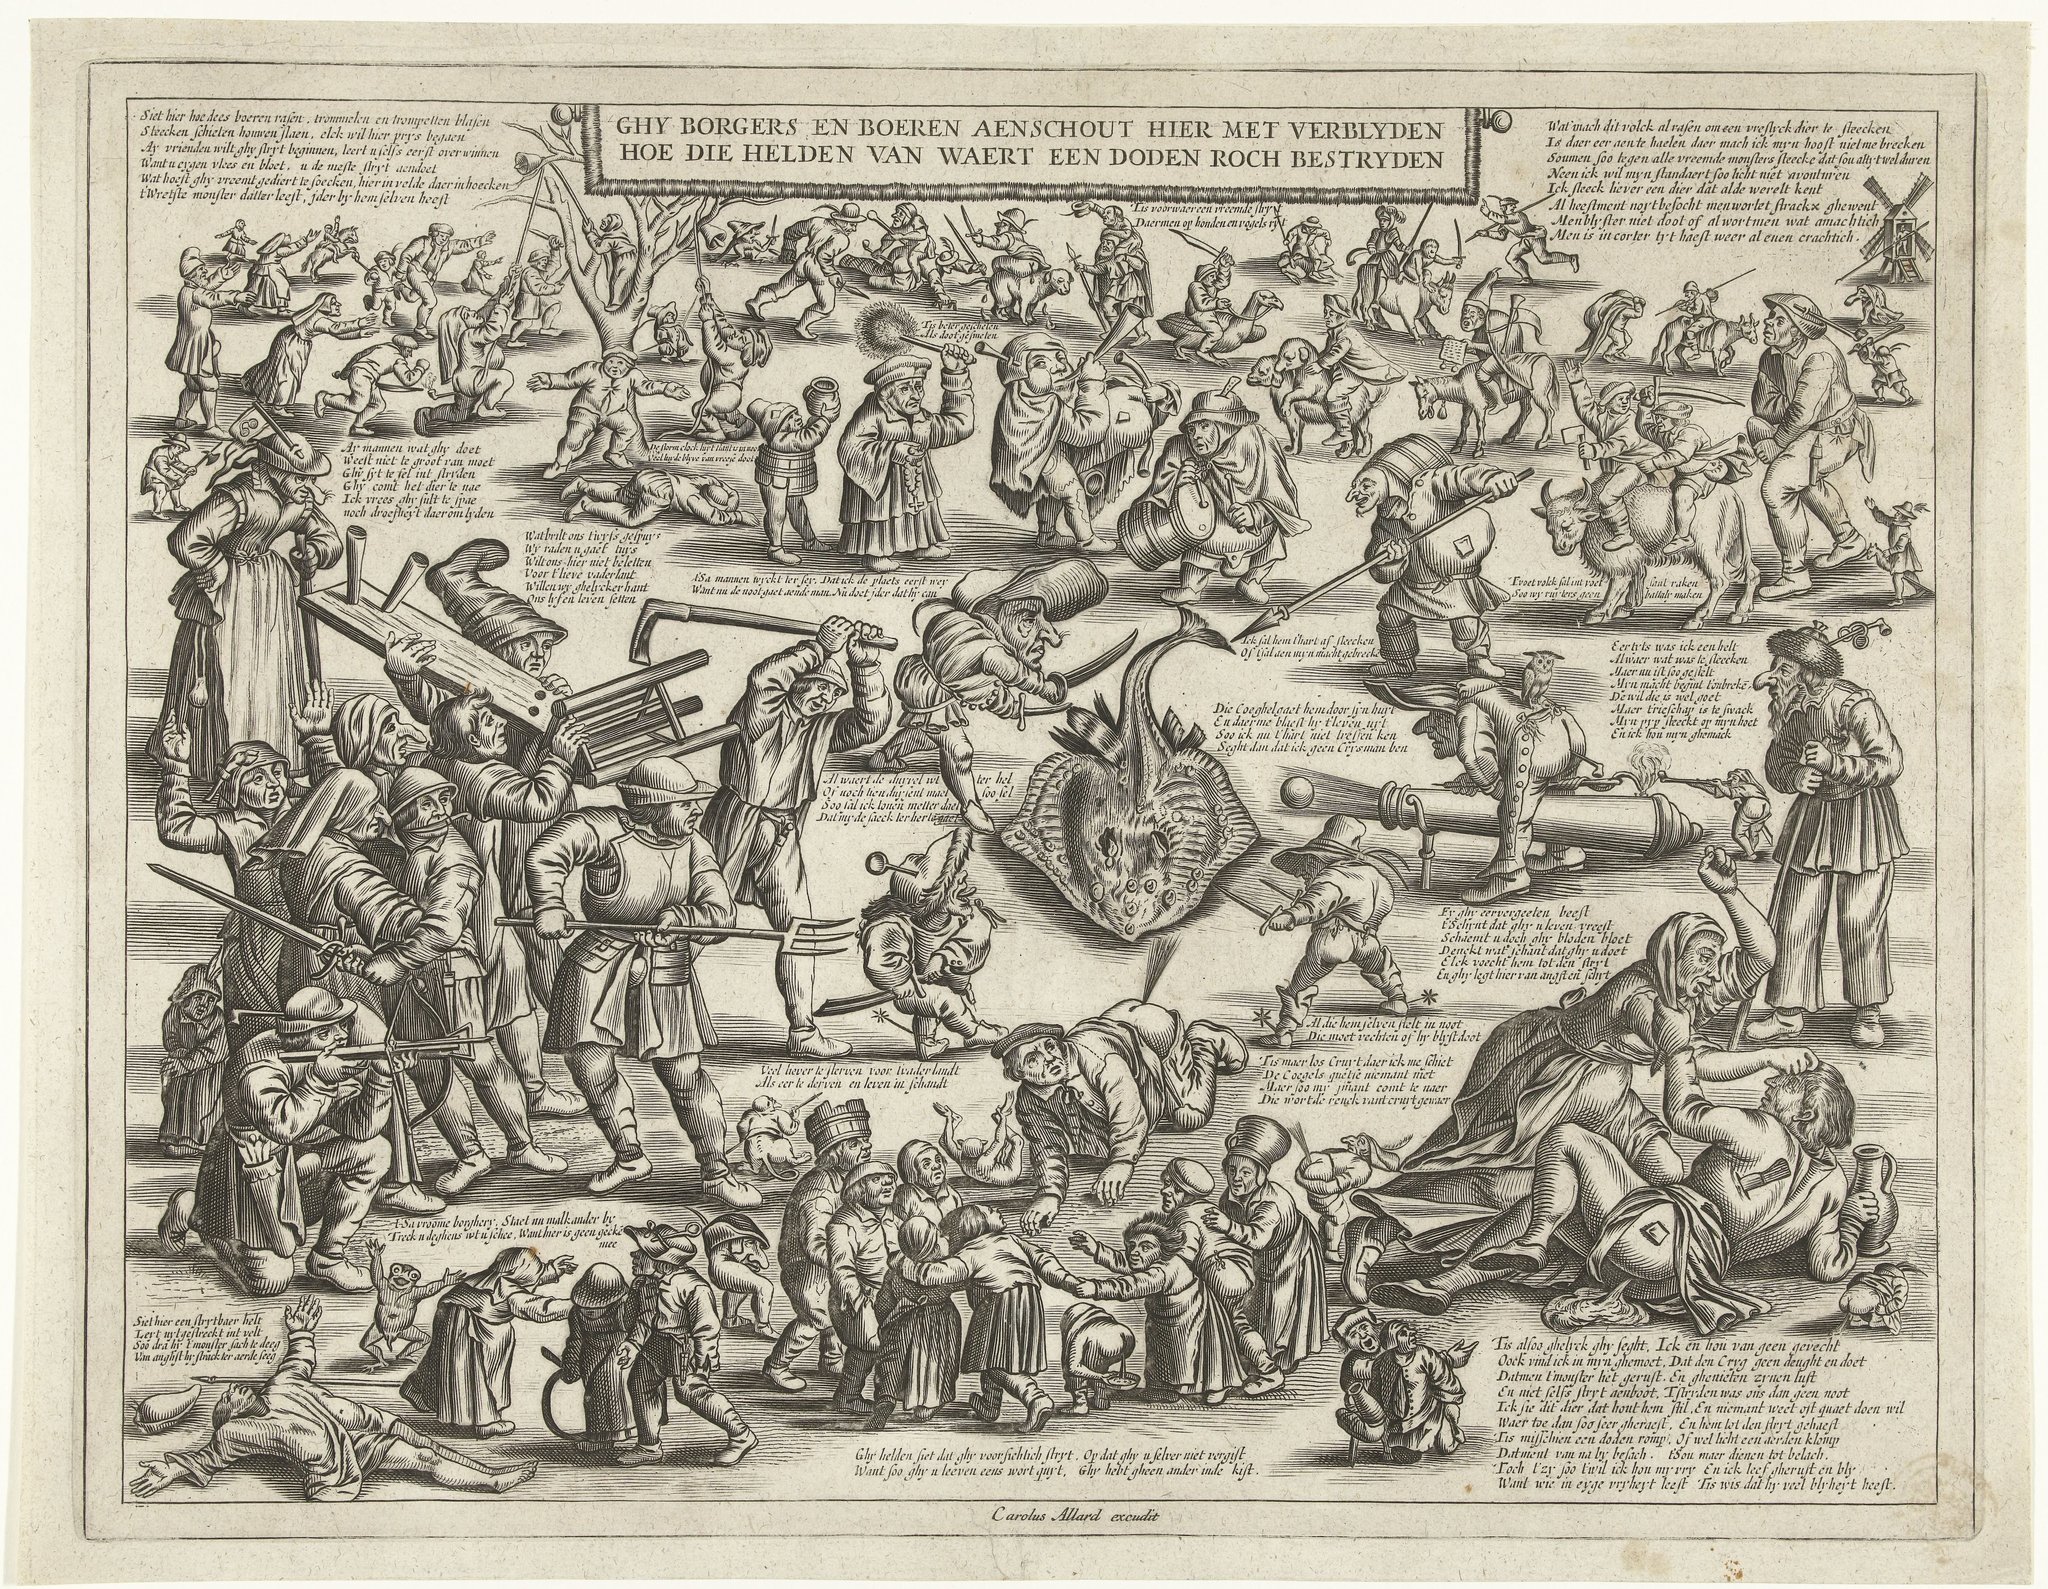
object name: print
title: Ghy borgers en boeren aenschout hier met verblyden hoe die helden van Waert een doden roch bestryden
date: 1660-1700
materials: paper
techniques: engraving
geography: amsterdam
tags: caricatures (human types)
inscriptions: collector's mark: Lugt 240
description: De Rogstekers van Weert, ca. 1650. Spotprent waarin allerlei verschillende dwazen in het plaatsje Waert (Weert in Limburg) ten strijde trekken tegen (het denkbeeldige gevaar van) een dode rog. In het midden een grote rog, waarop een kanon wordt afgevuurd. Rechtsachter een molen; linksachter een boom waaraan een klok die wordt geluid. Over het hele blad talloze figuren met verschillende attributen en verklarende teksten. In drie hoeken langere verzen.